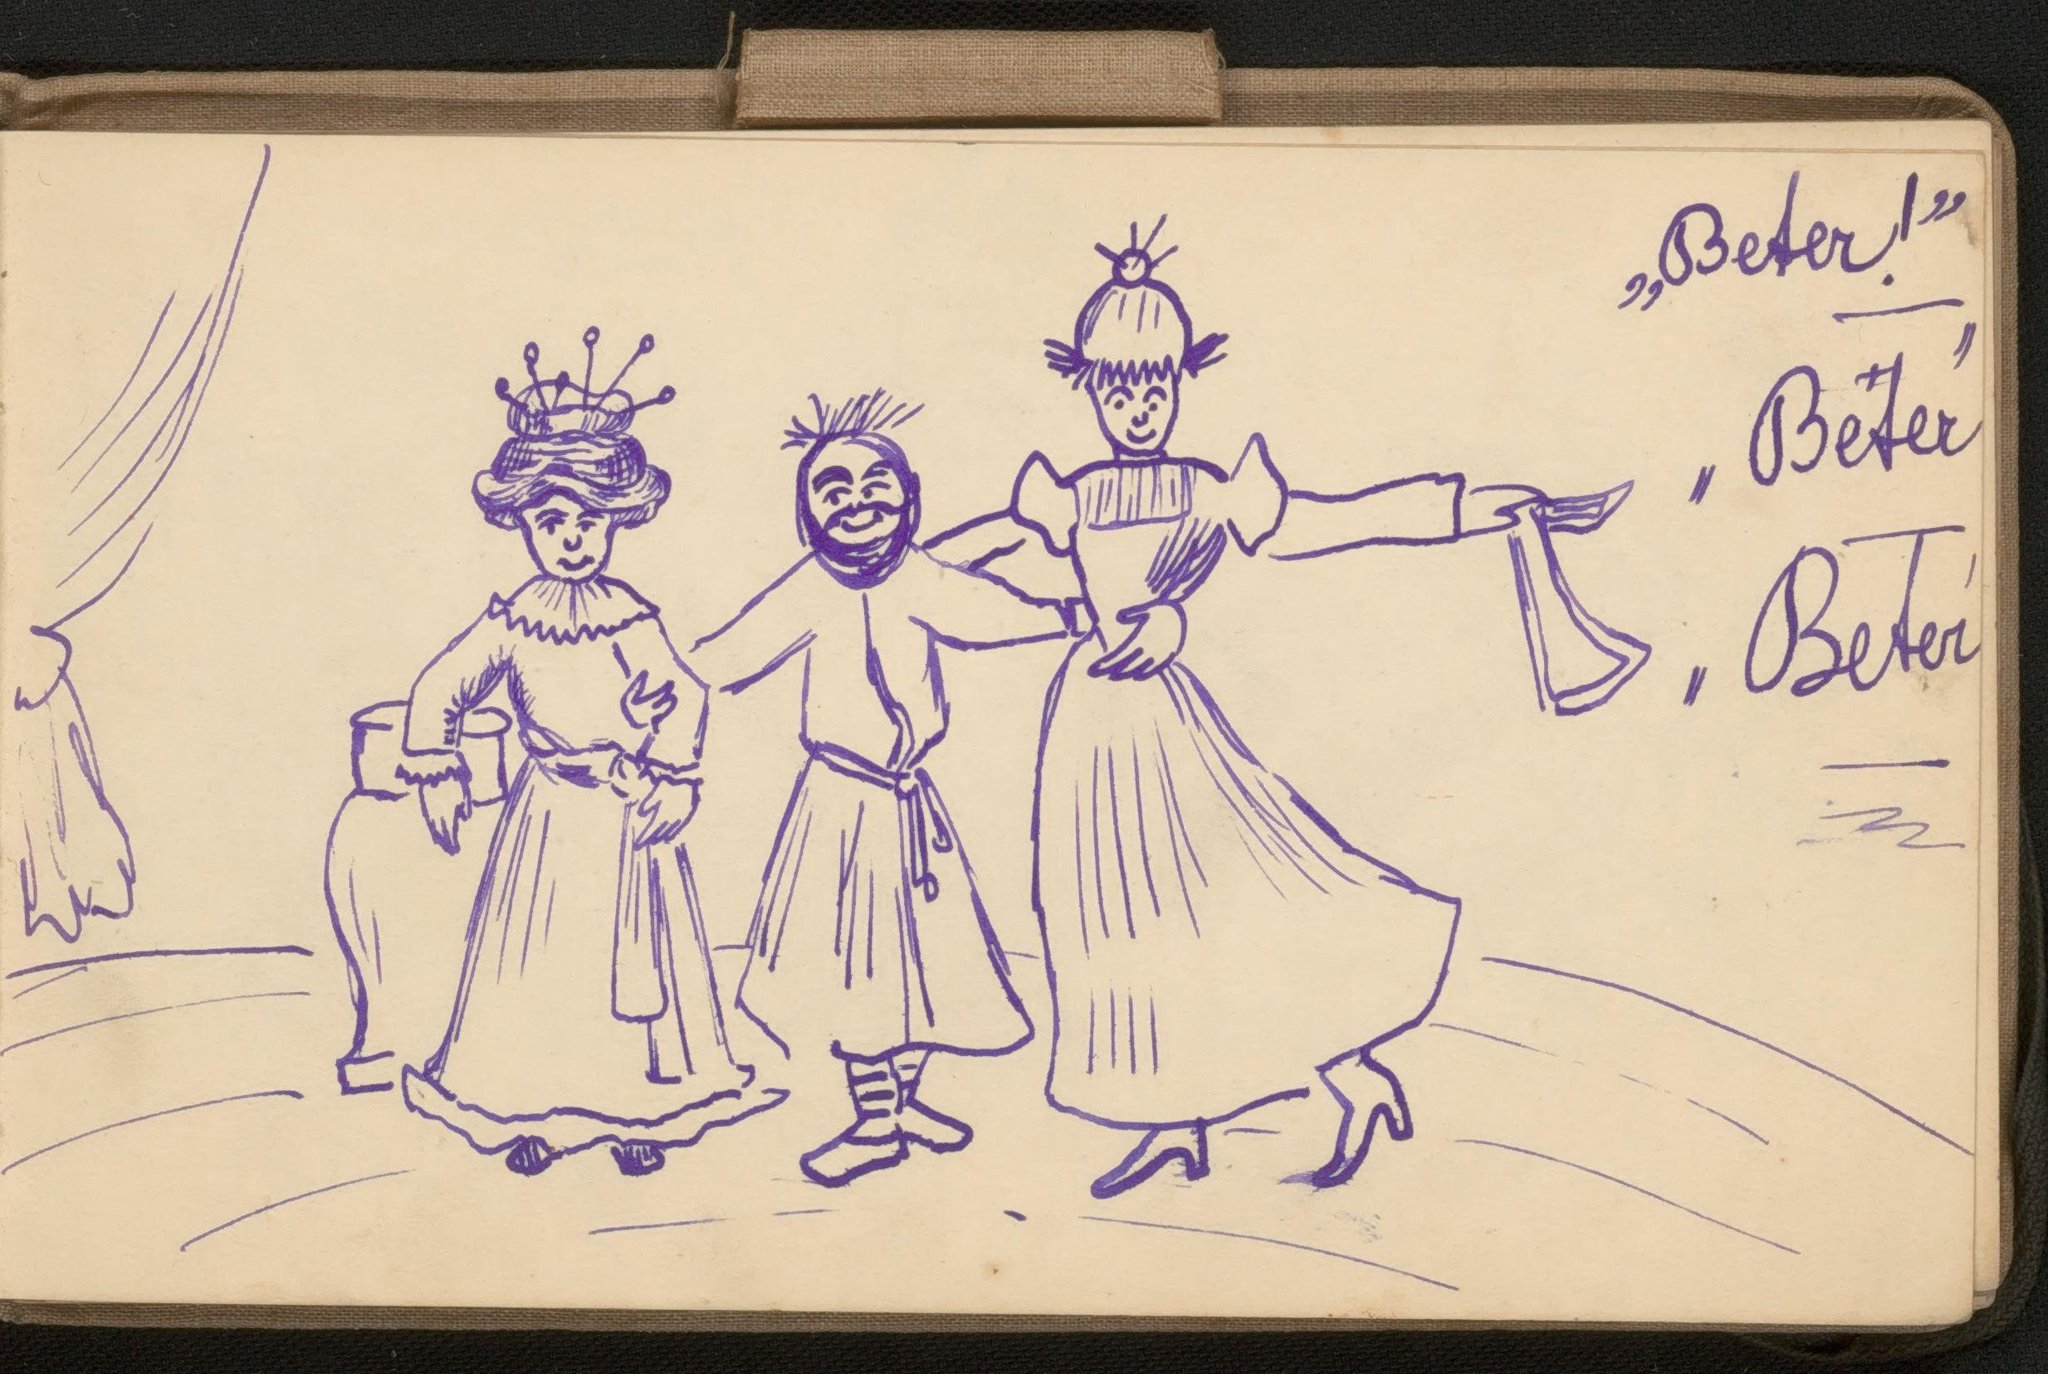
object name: sketchbook leaf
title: Beter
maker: Anonymous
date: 1875-1920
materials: ink, paper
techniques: pen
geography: netherlands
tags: family life at home, recovery, convalescence of sick person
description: Het gezin is weer beter. Onderdeel van het schetsboek met humoristische tekeningen over het leven van een 'famille nombreuse'. Onderwerpsrubrieken binnen de Atlas Zeden en Gewoonten: Zeden en Gewoonten in Engeren Zin, Des menschen beging, midden en einde, Kinderleven.